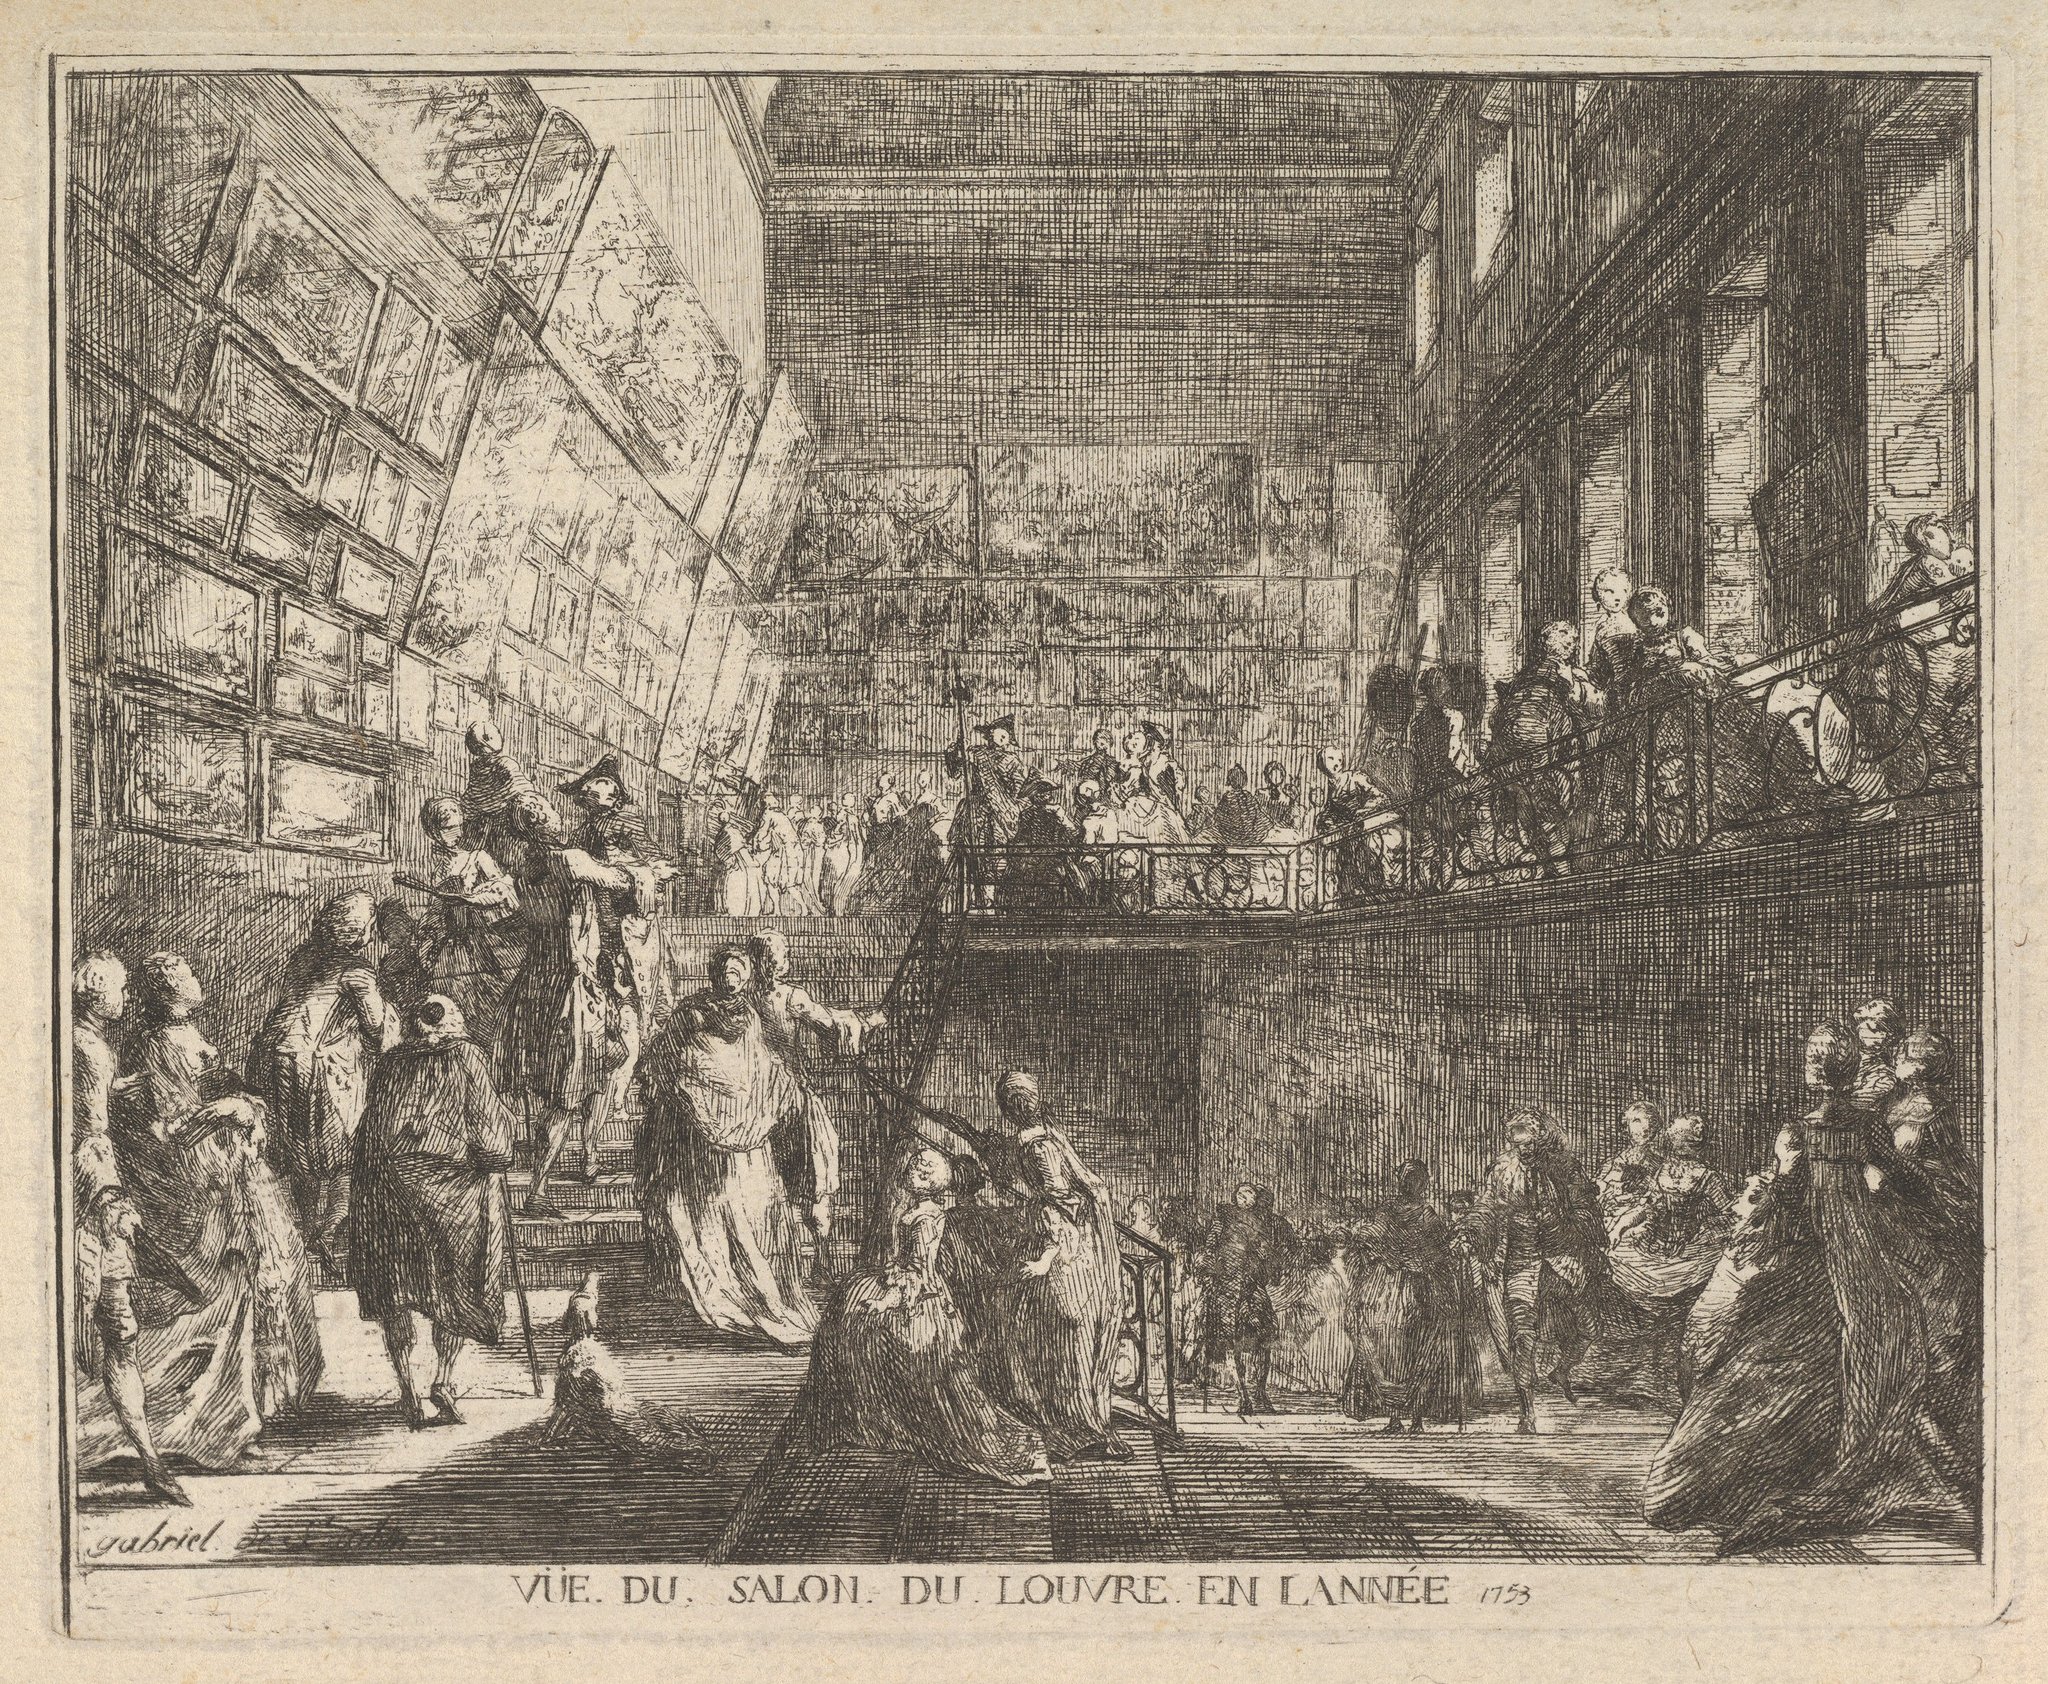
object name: print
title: View of the Salon in the Year 1753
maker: gabriel de saint-aubin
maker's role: artist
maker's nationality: french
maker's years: 1724-1780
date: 1753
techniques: etching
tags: painting,interiors,men,women